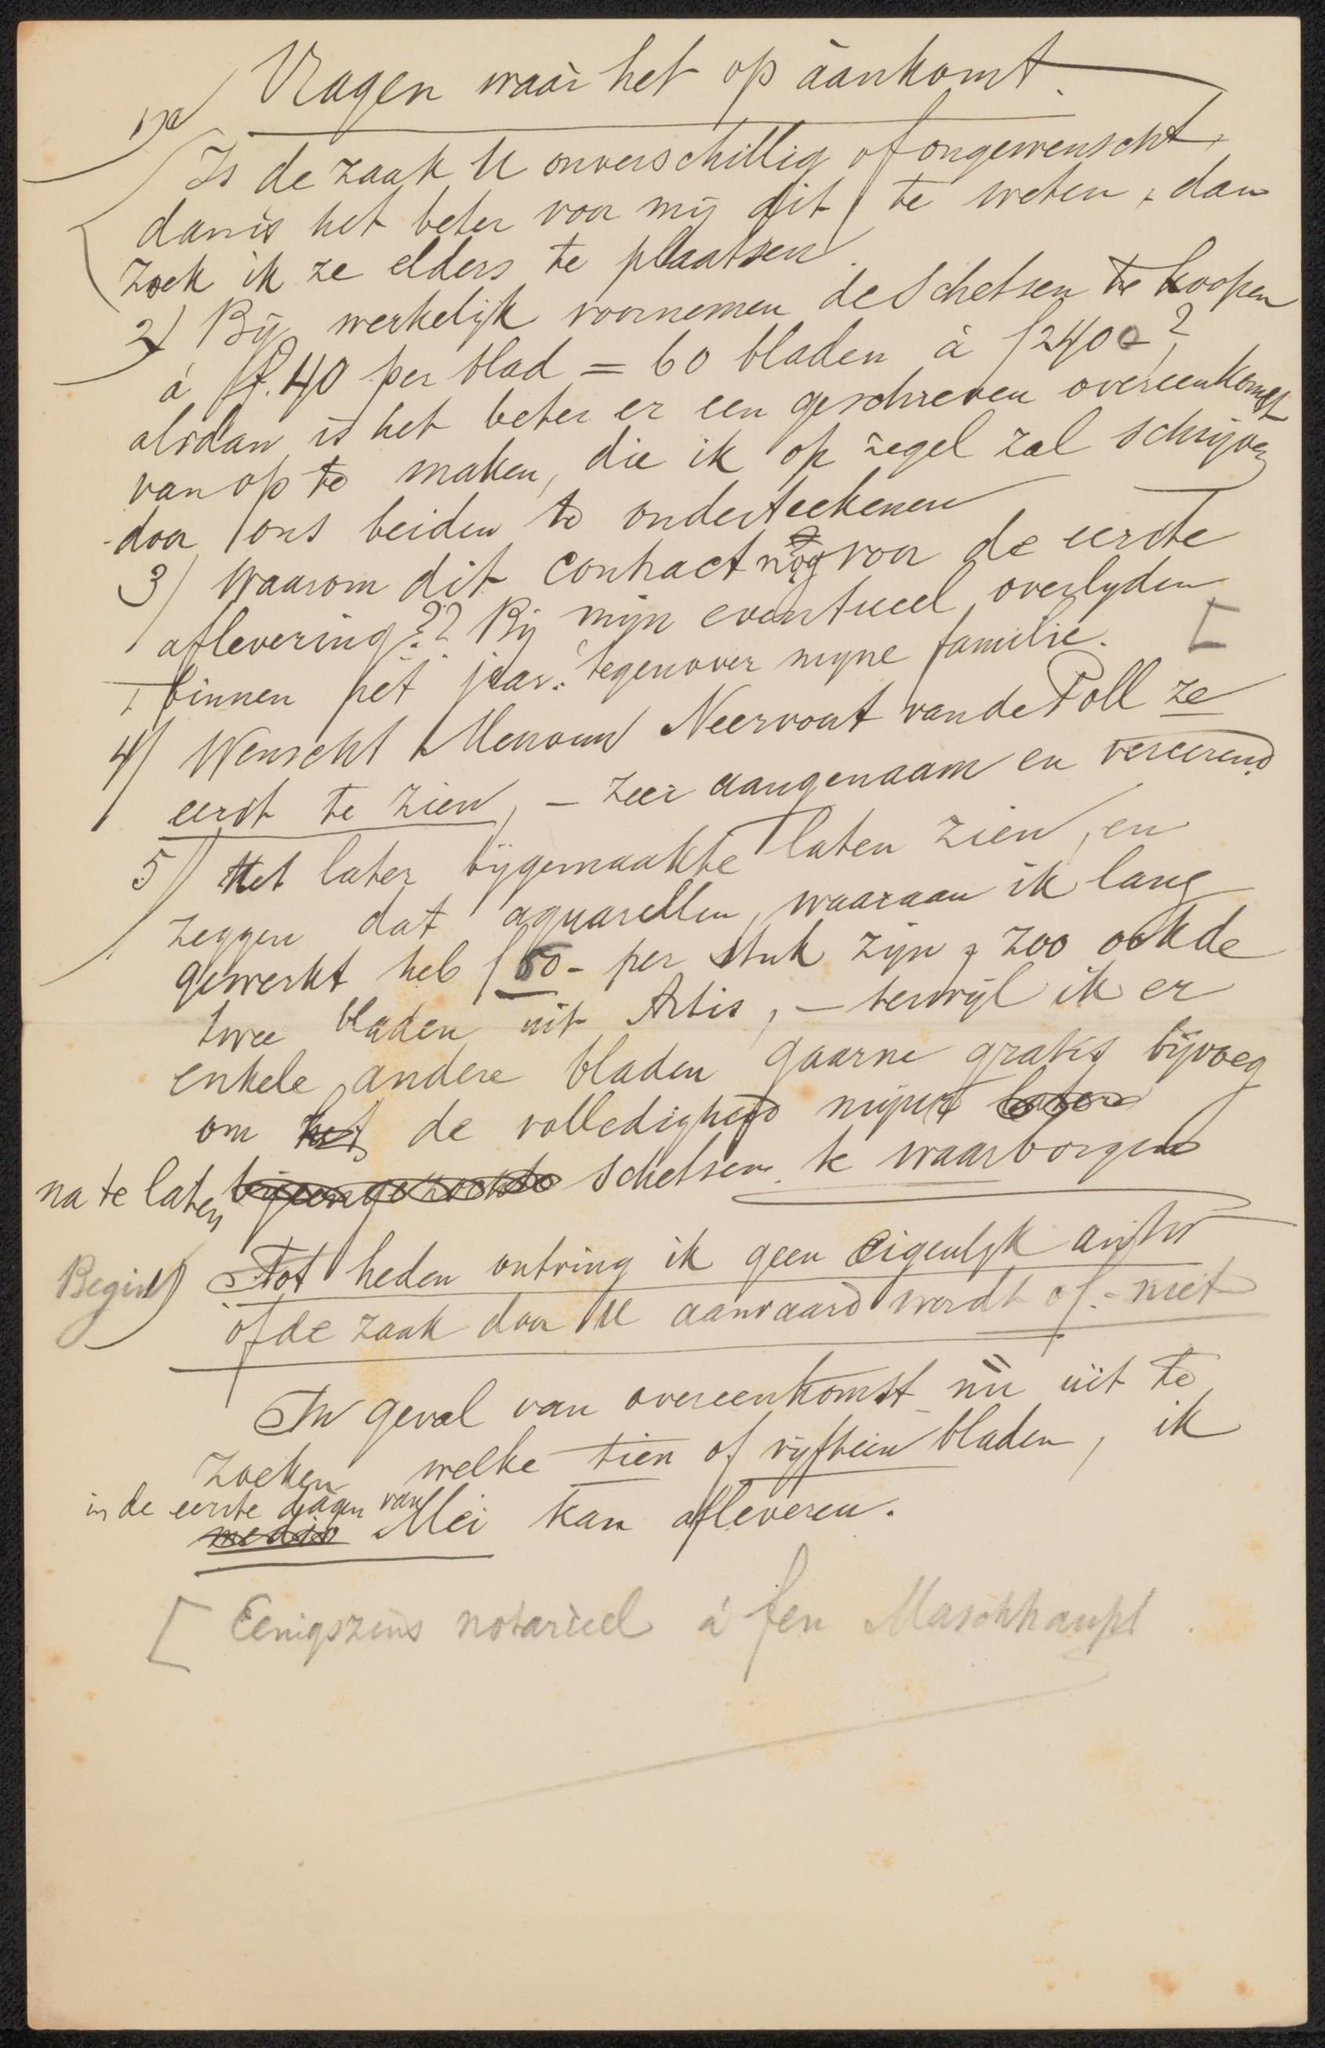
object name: aantekening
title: Aantekening uit collectie August Allebé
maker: august allebé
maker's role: draughtsman, print maker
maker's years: 1838-1927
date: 1848-1927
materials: ink, paper, pencil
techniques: pen, writing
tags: art trade, art shop, drawing, money